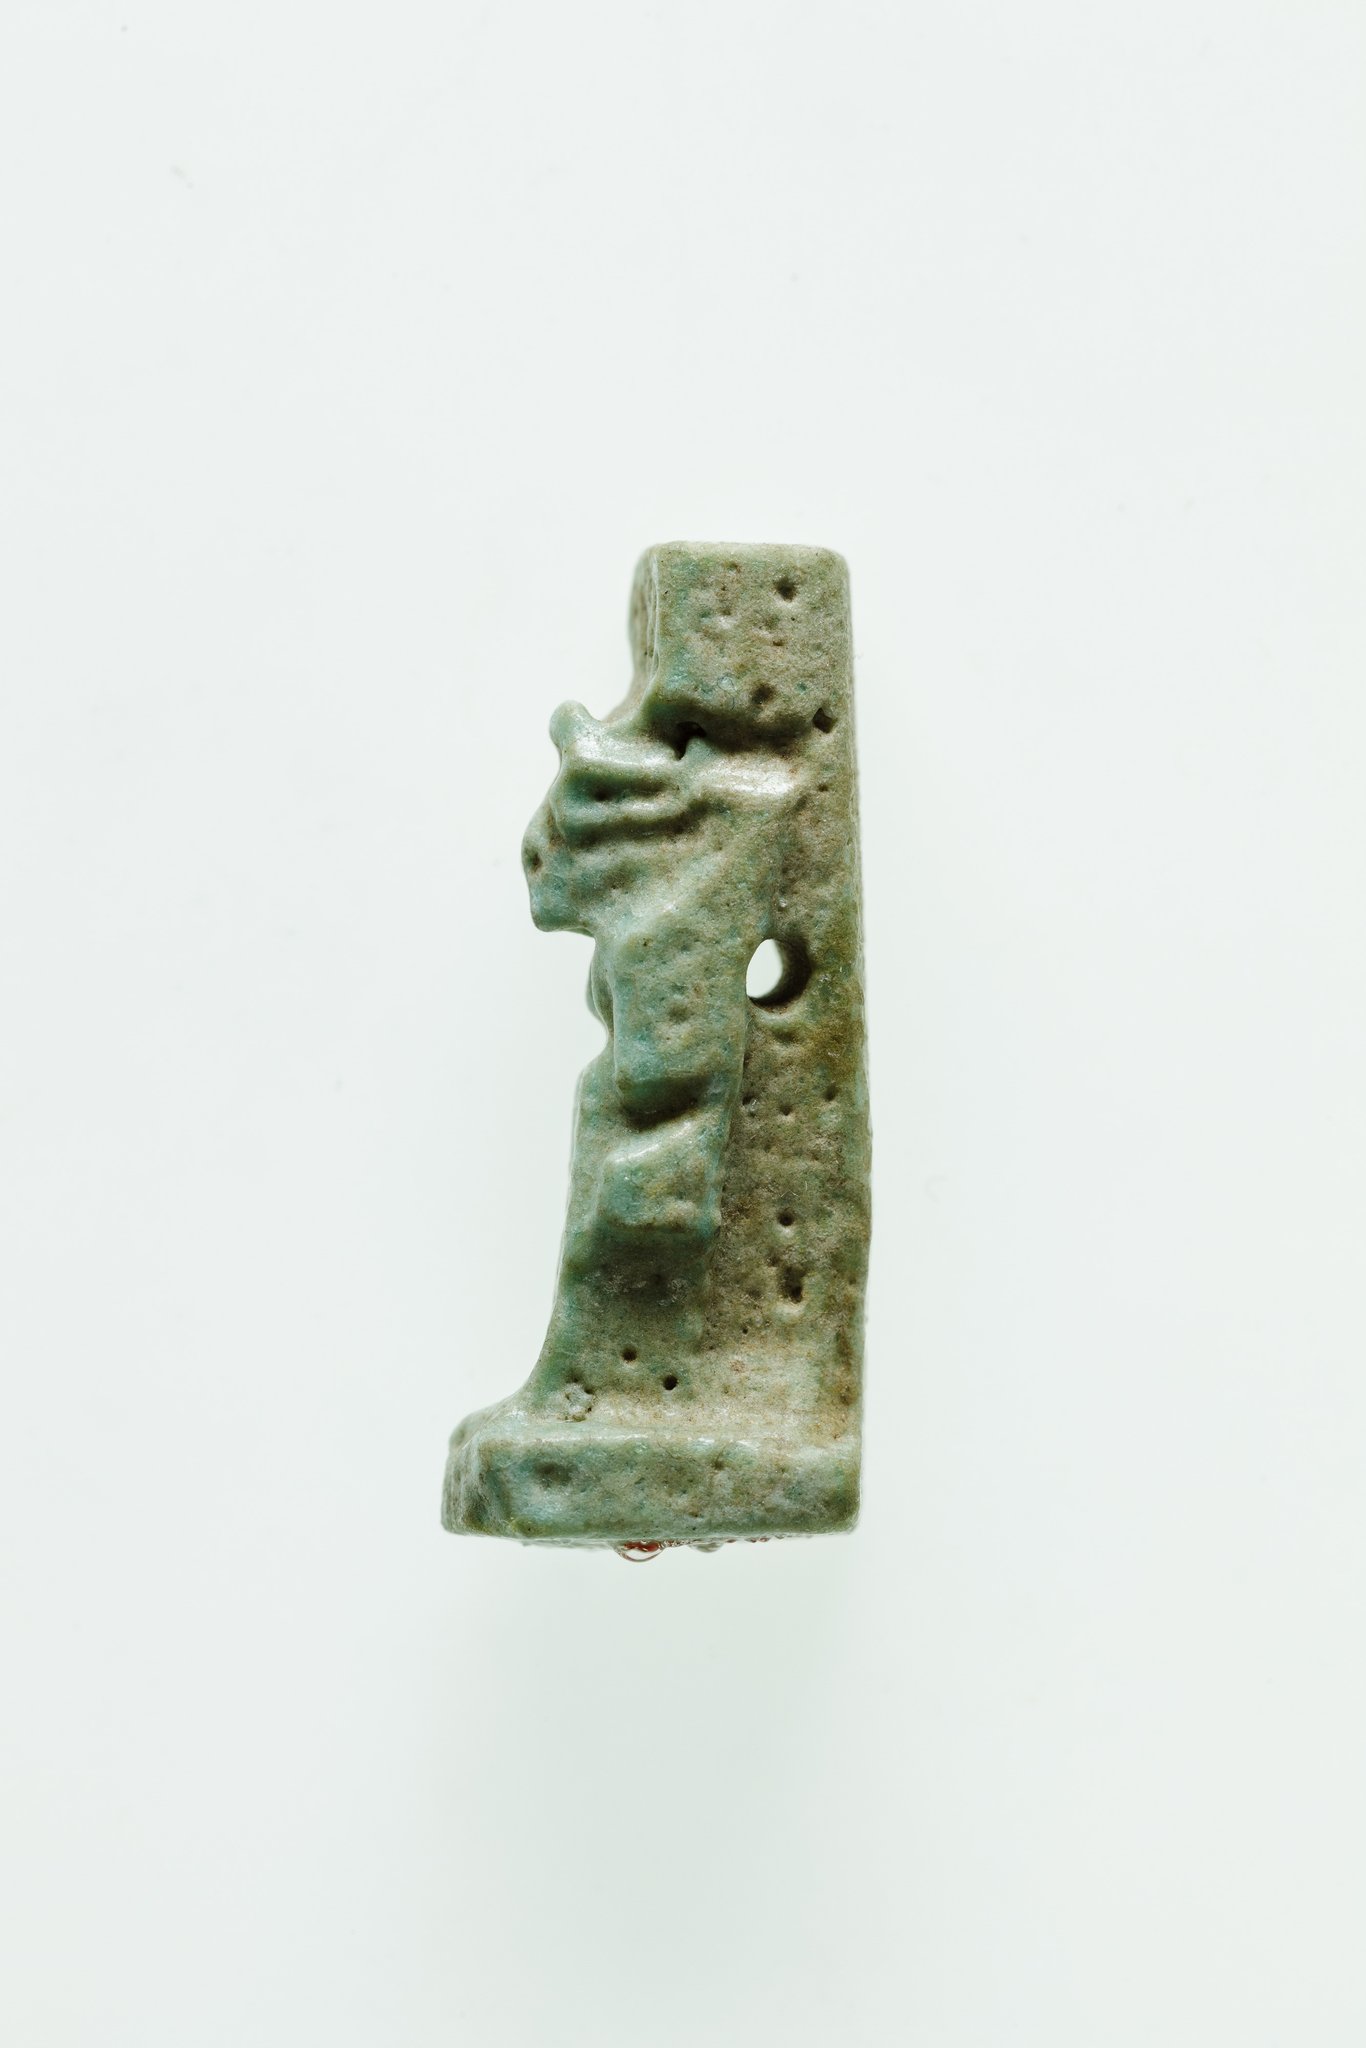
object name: amulet, nephthys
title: Amulet of a goddess, possibly Nephthys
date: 1086 BCE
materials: faience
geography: egypt